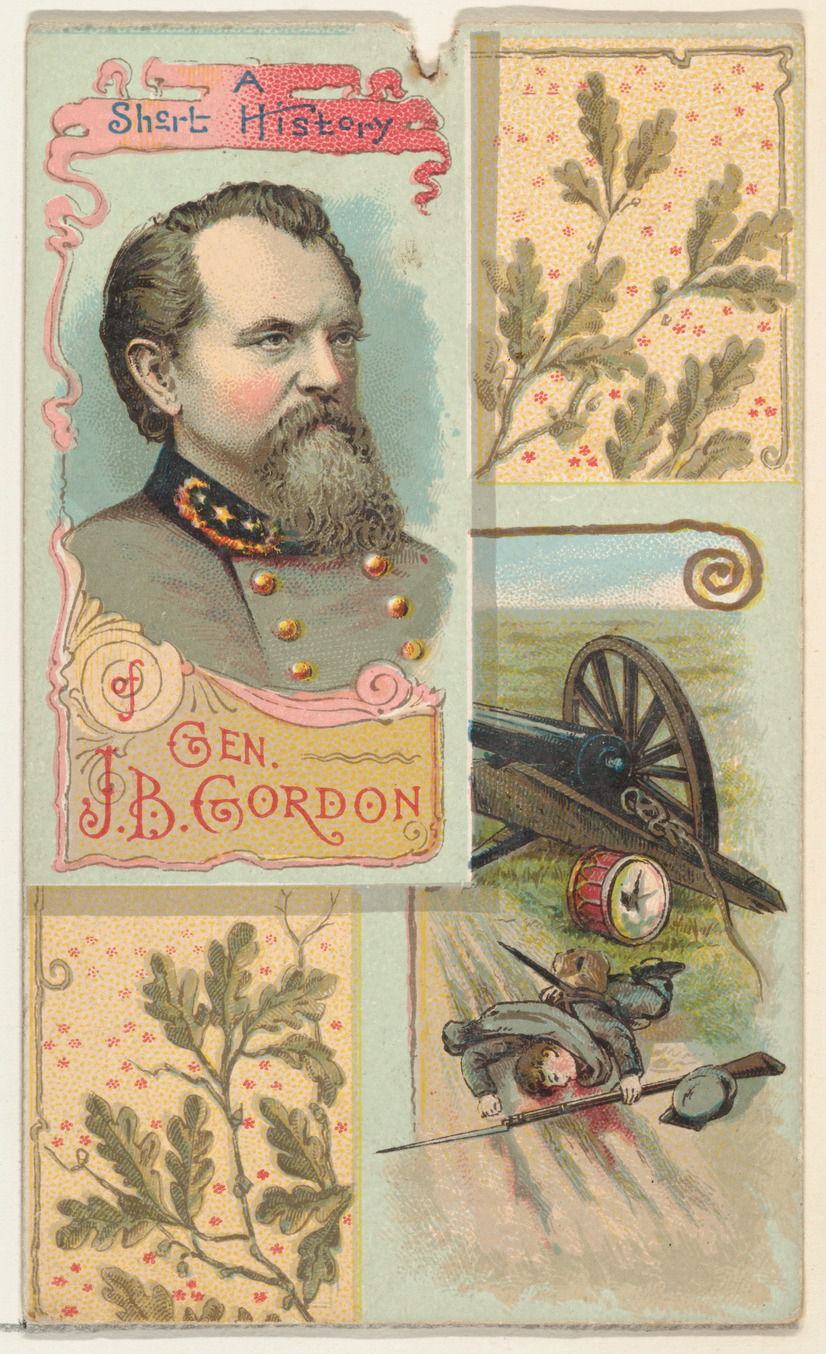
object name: print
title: A Short History: General John Brown Gordon, from the Histories of Generals series (N114) issued by W. Duke, Sons & Co. to promote Honest Long Cut Smoking and Chewing Tobacco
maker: w. duke, sons & co.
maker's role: publisher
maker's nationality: american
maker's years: 1870-1920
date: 1888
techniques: color lithograph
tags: cannons,men,portraits,death,generals